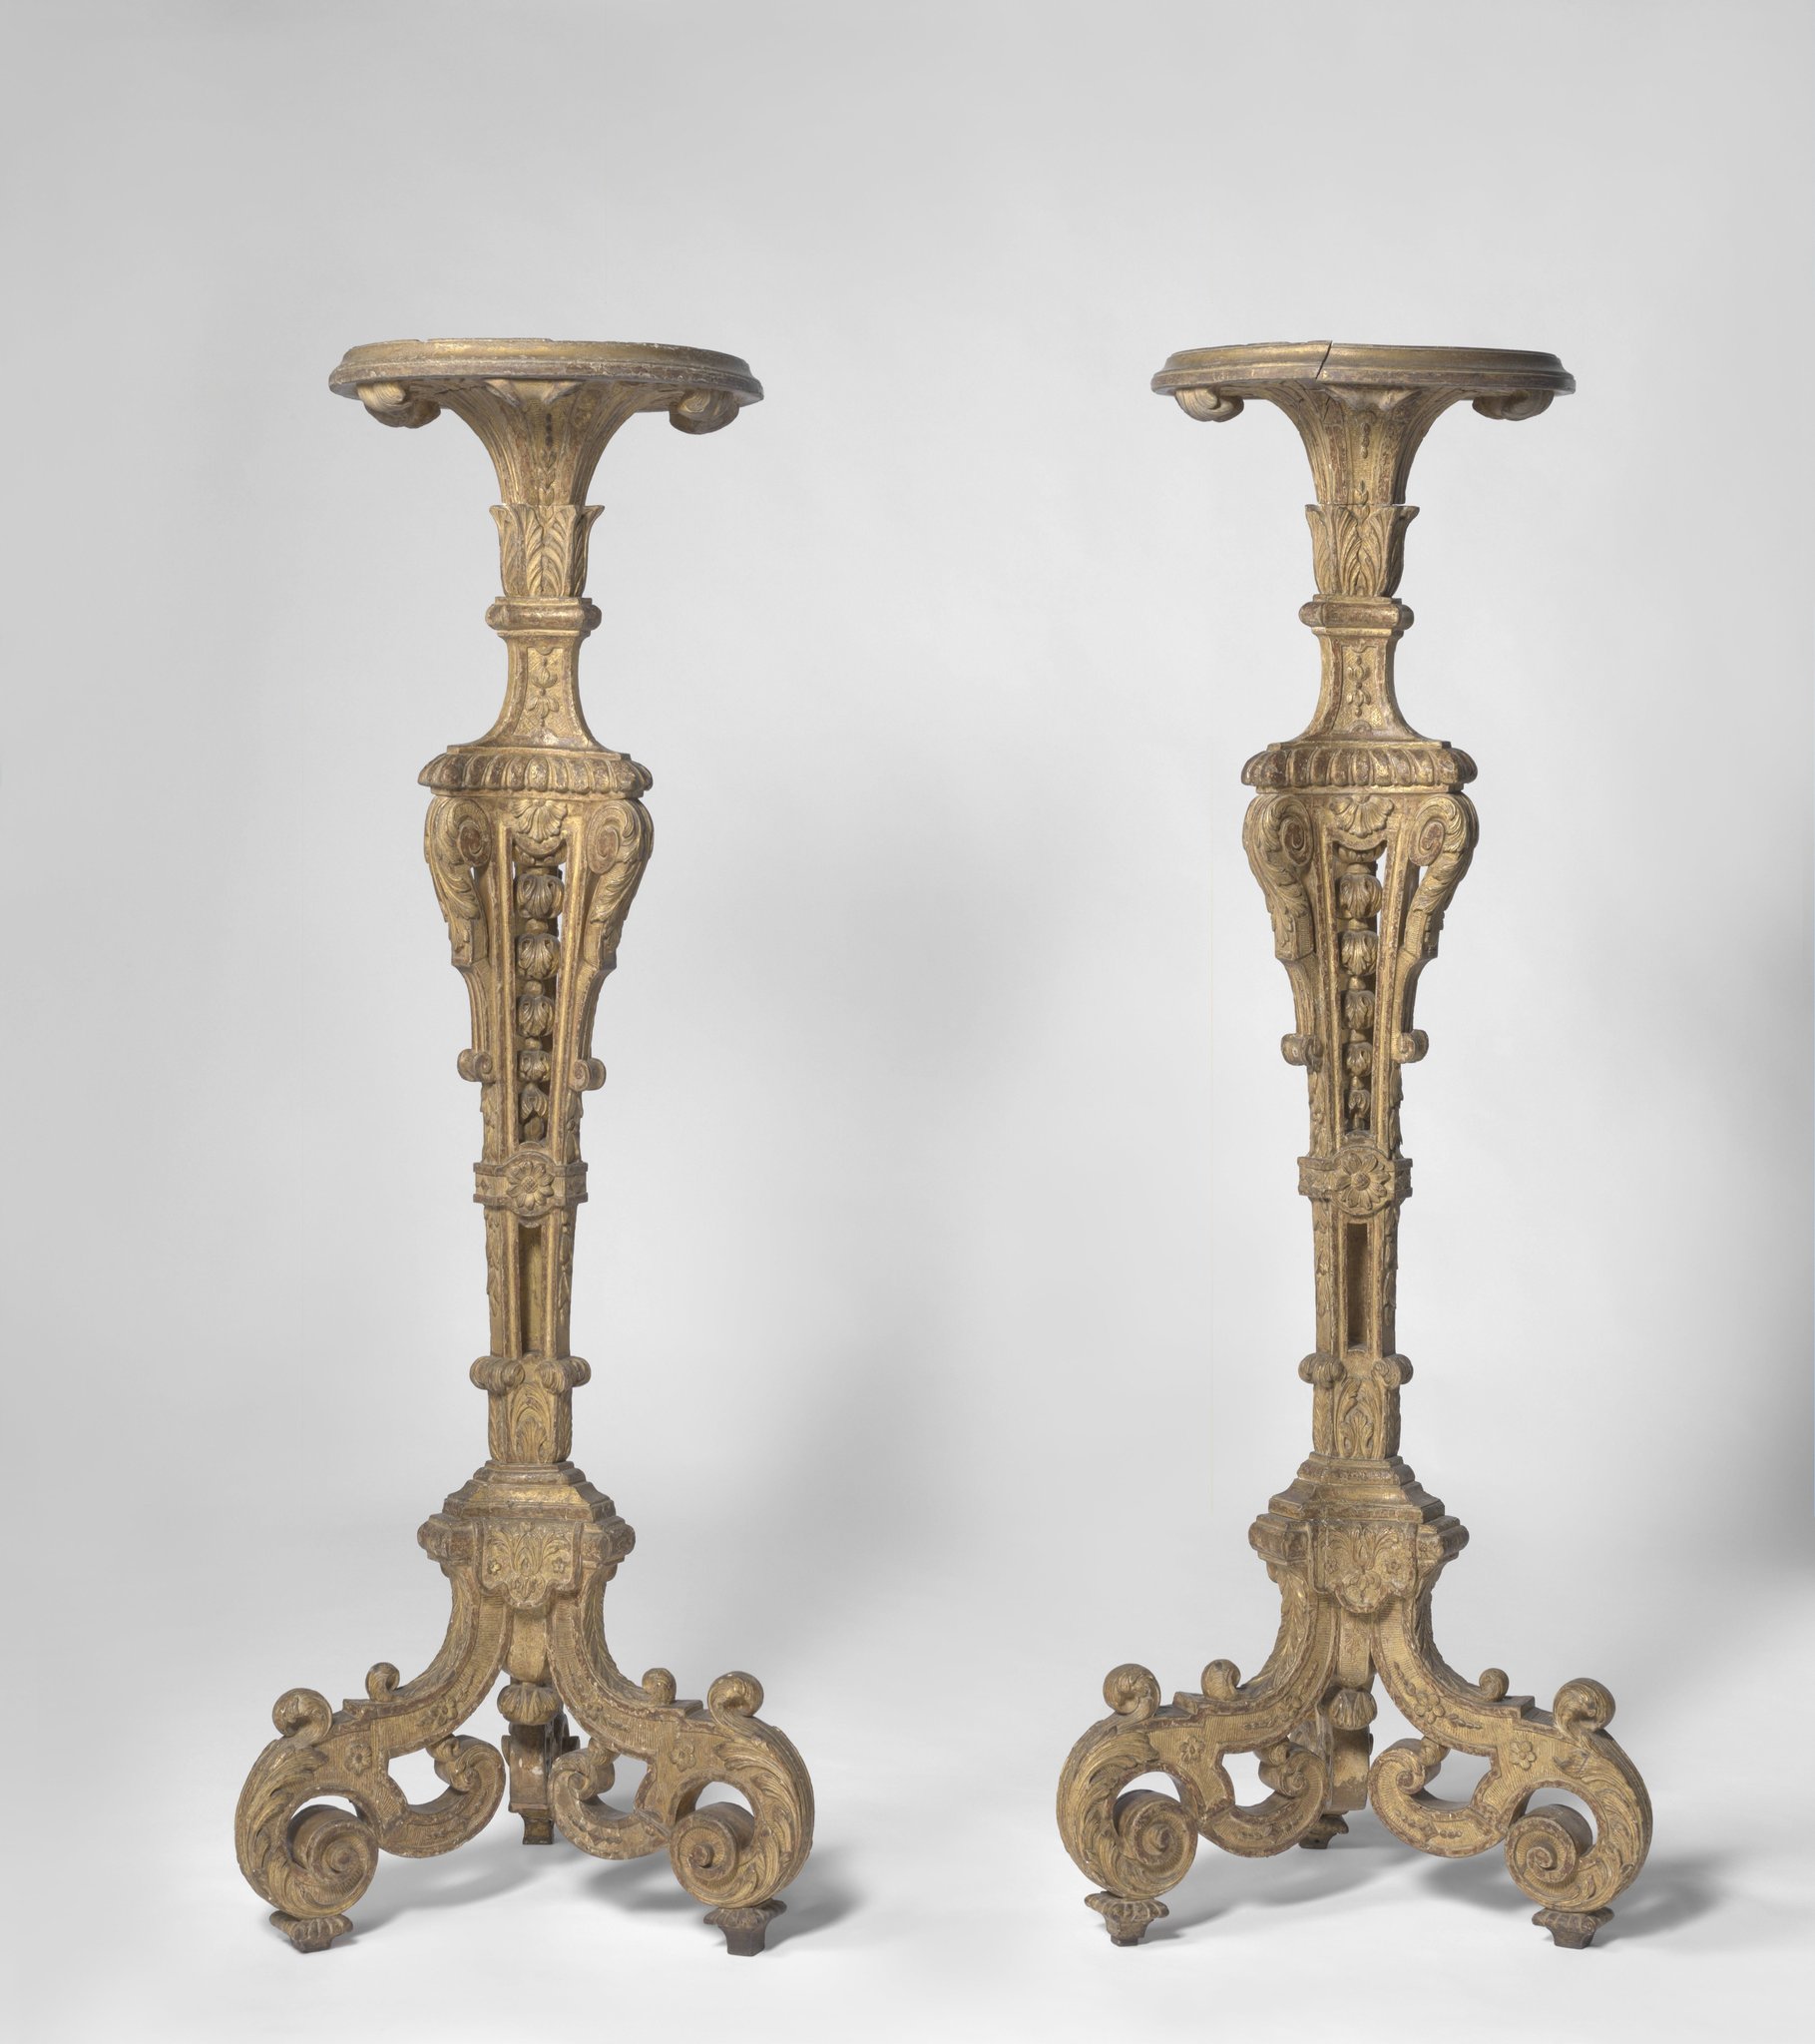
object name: furniture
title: Two Candlestands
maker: Anonymous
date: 1685-1700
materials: wood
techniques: gilding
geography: paris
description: Large candlestands of this type served to support candelabra for three or more candles. They stood in the corners of sumptuously furnished interiors, or sometimes in larger series along galleries. At the end of the seventeenth century large numbers of comparable candlestands were delivered for the palace at Versailles. The French model was also copied in England and the Netherlands.